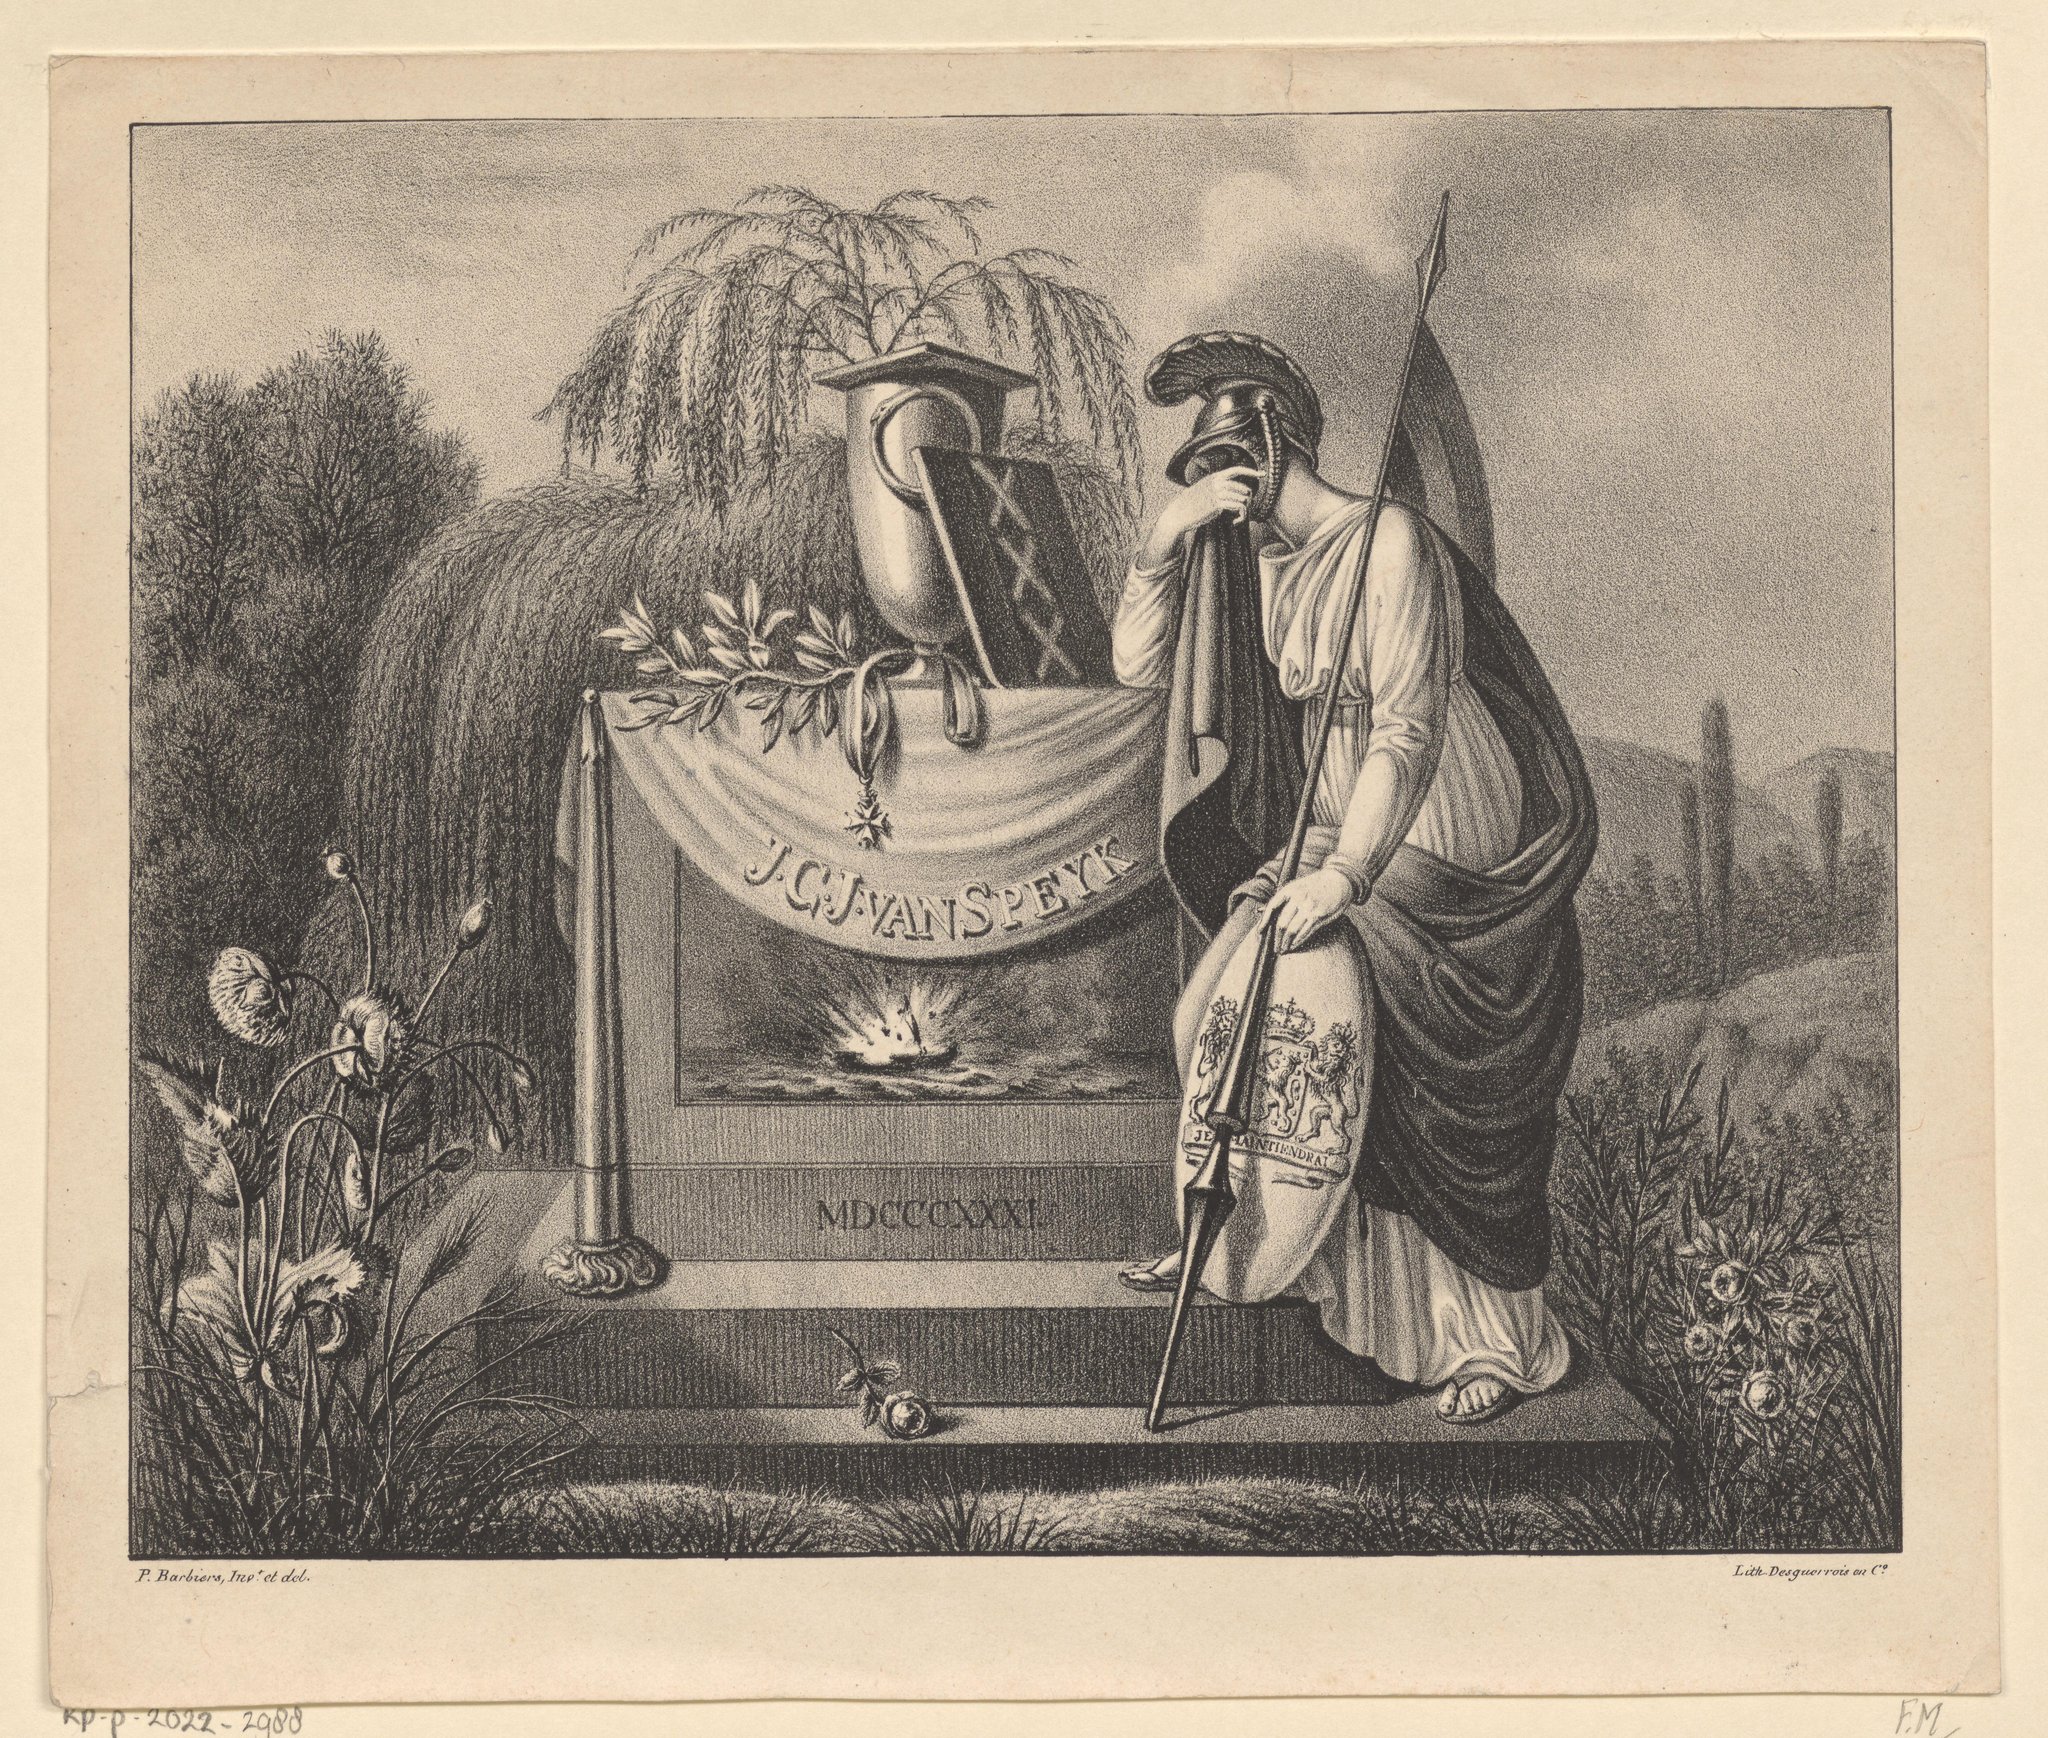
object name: print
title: Grafmonument voor Jan van Speyk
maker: pieter barbiers (iv)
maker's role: painter, print maker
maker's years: 1798-1848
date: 1831-1848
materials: paper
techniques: lithograph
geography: amsterdam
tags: amsterdam, antwerp, jan van speyk, historical persons, commander-in-chief, admiral